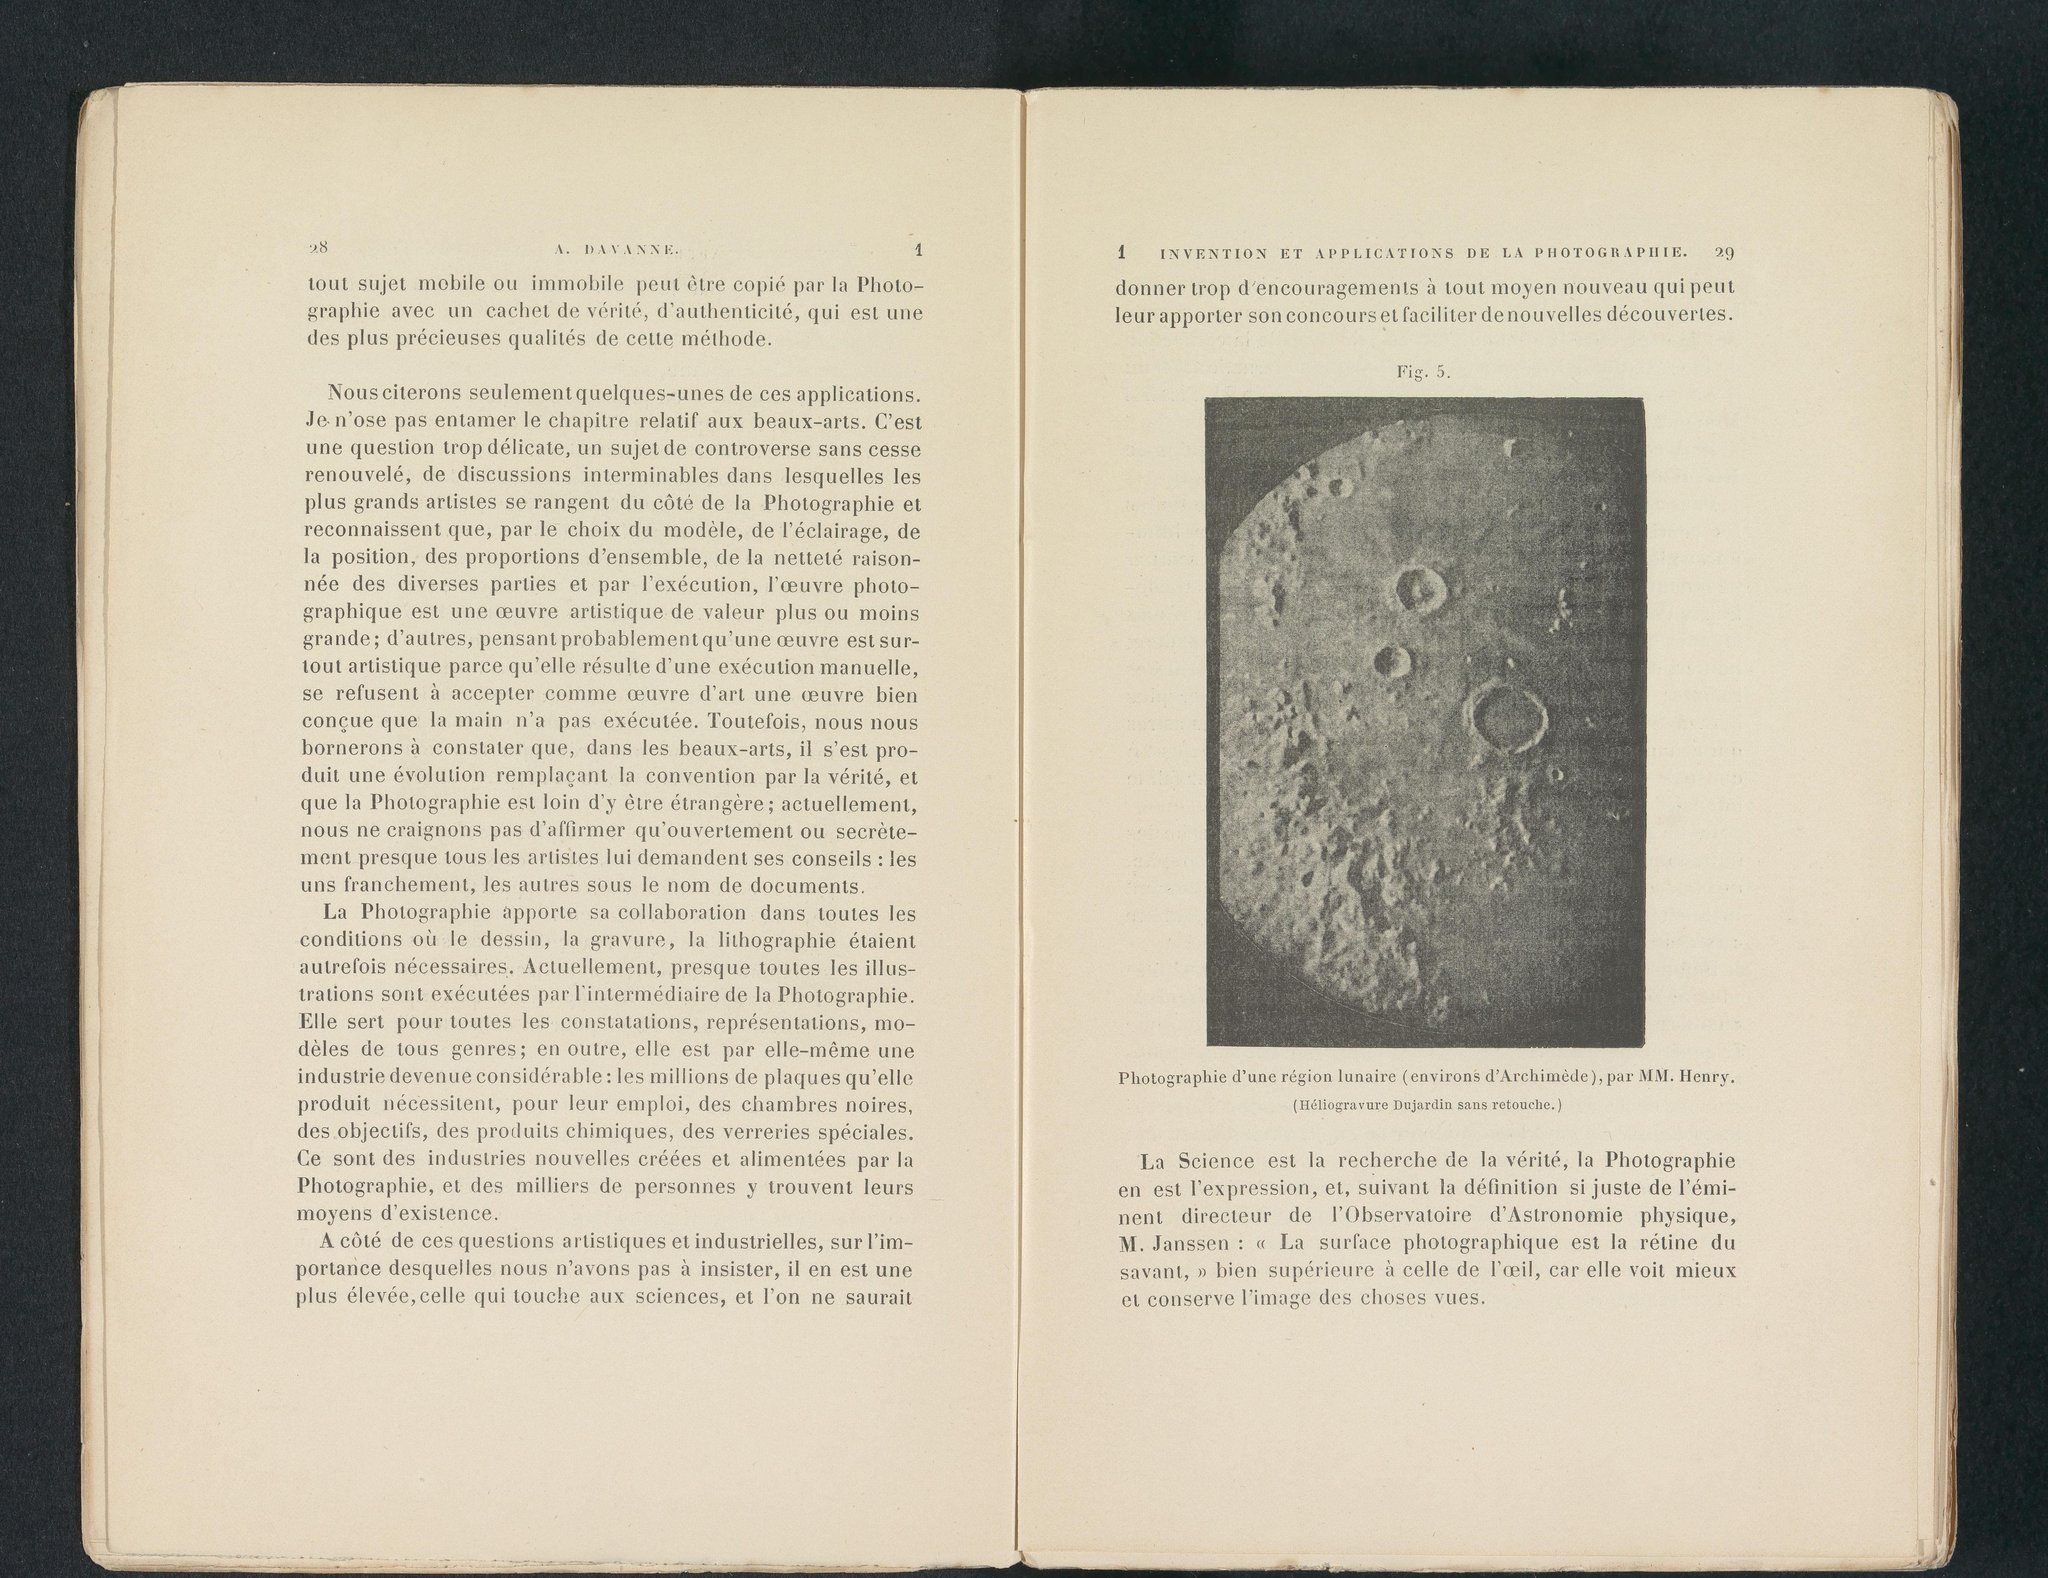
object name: photomechanical print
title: Maanoppervlak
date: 1850-1870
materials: paper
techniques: photoaquatint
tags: surface of the moon, moon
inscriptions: number: ‘Fig. 5.’, inscription: ‘Photographie d'une région lunaire (...) par M. M. Henry.’